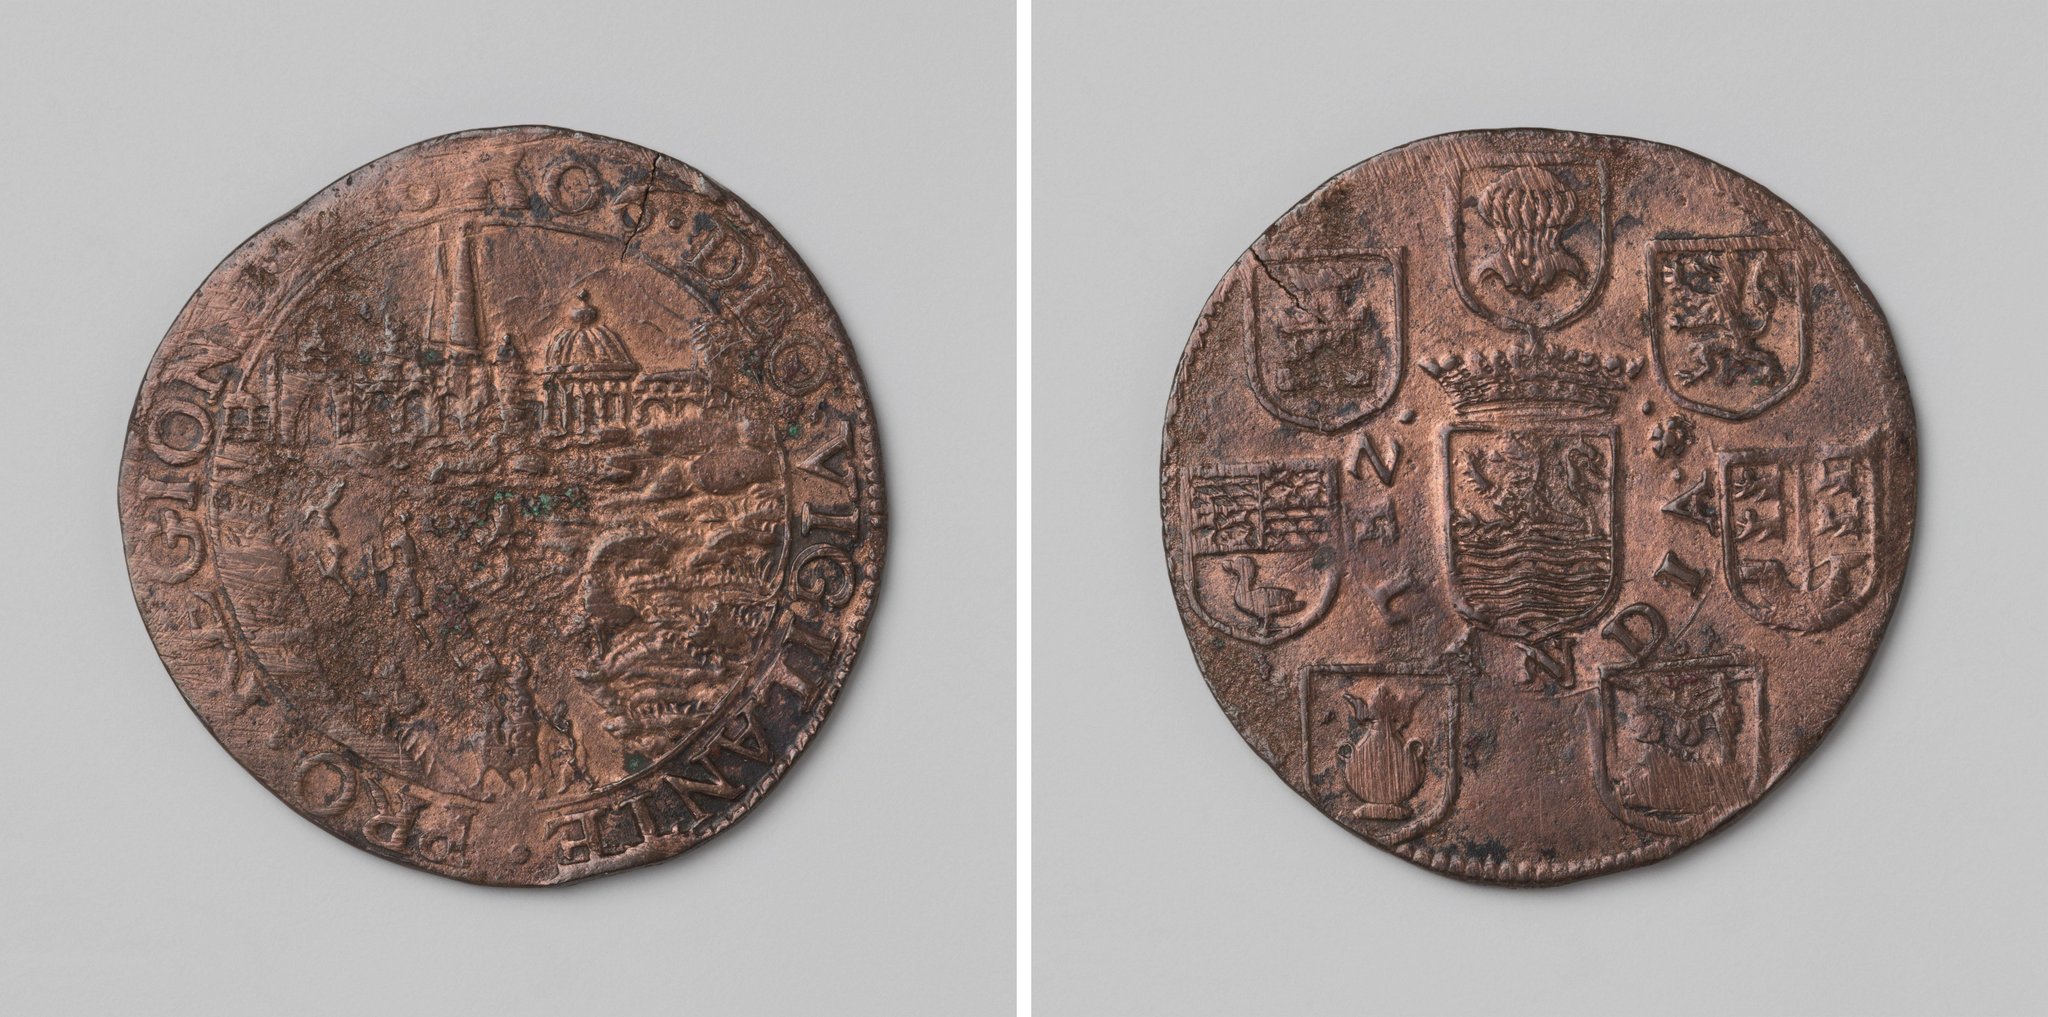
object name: jeton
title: Goddelijke bijstand aan de opstandelingen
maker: Anonymous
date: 1606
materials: copper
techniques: striking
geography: middelburg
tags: zeeland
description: Koperen penning. Voorzijde: drukke weg leidend naar stad binnen omschrift. Keerzijde: gekroond wapenschild binnen omschrift en rand van zeven wapenschilden